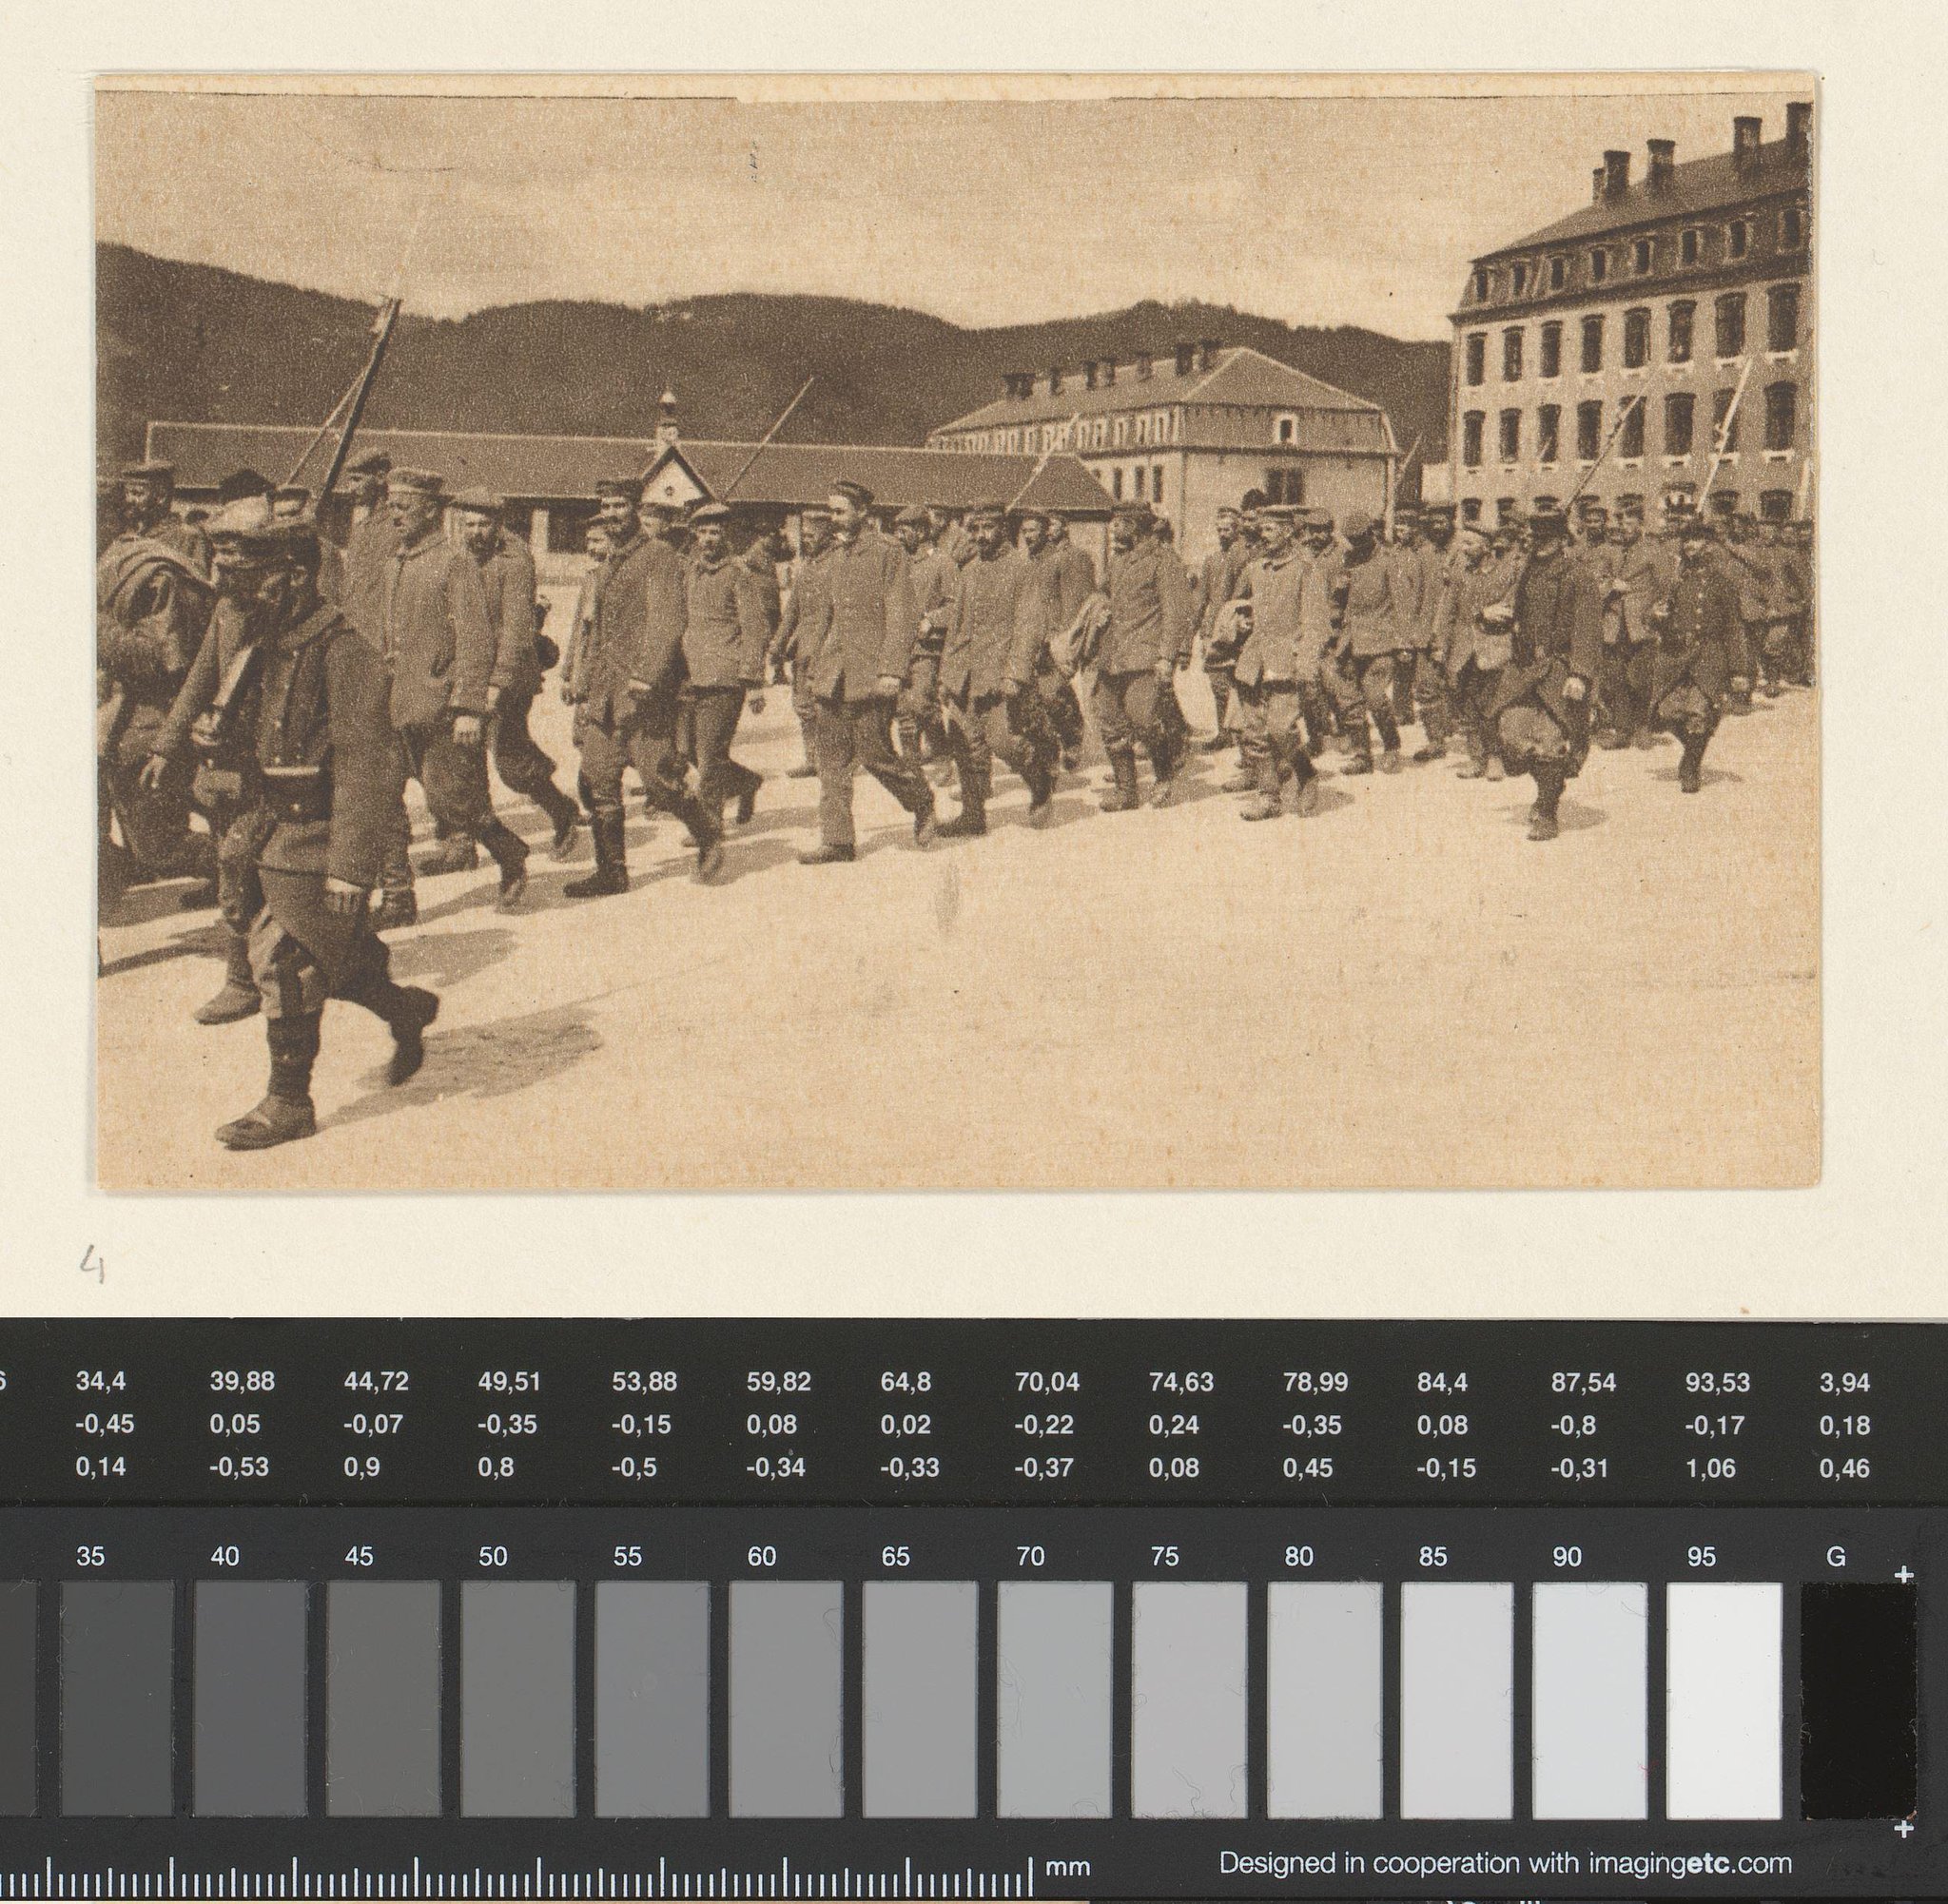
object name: ansichtkaart, prentbriefkaart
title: 12 cartes postales illustrées de la Grande Guerre / Pochette No 1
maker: sémaphore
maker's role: printer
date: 1914-1915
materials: paper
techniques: photograph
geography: marseille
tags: transfer, deportation ~ prisoner of war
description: Defilé van Duitse krijgsgevangen in Lotharingen. Onderdeel van de eerste serie van twaalf (elf aanwezig) prentbriefkaarten over de Eerste Wereldoorlog, 1914-1915.